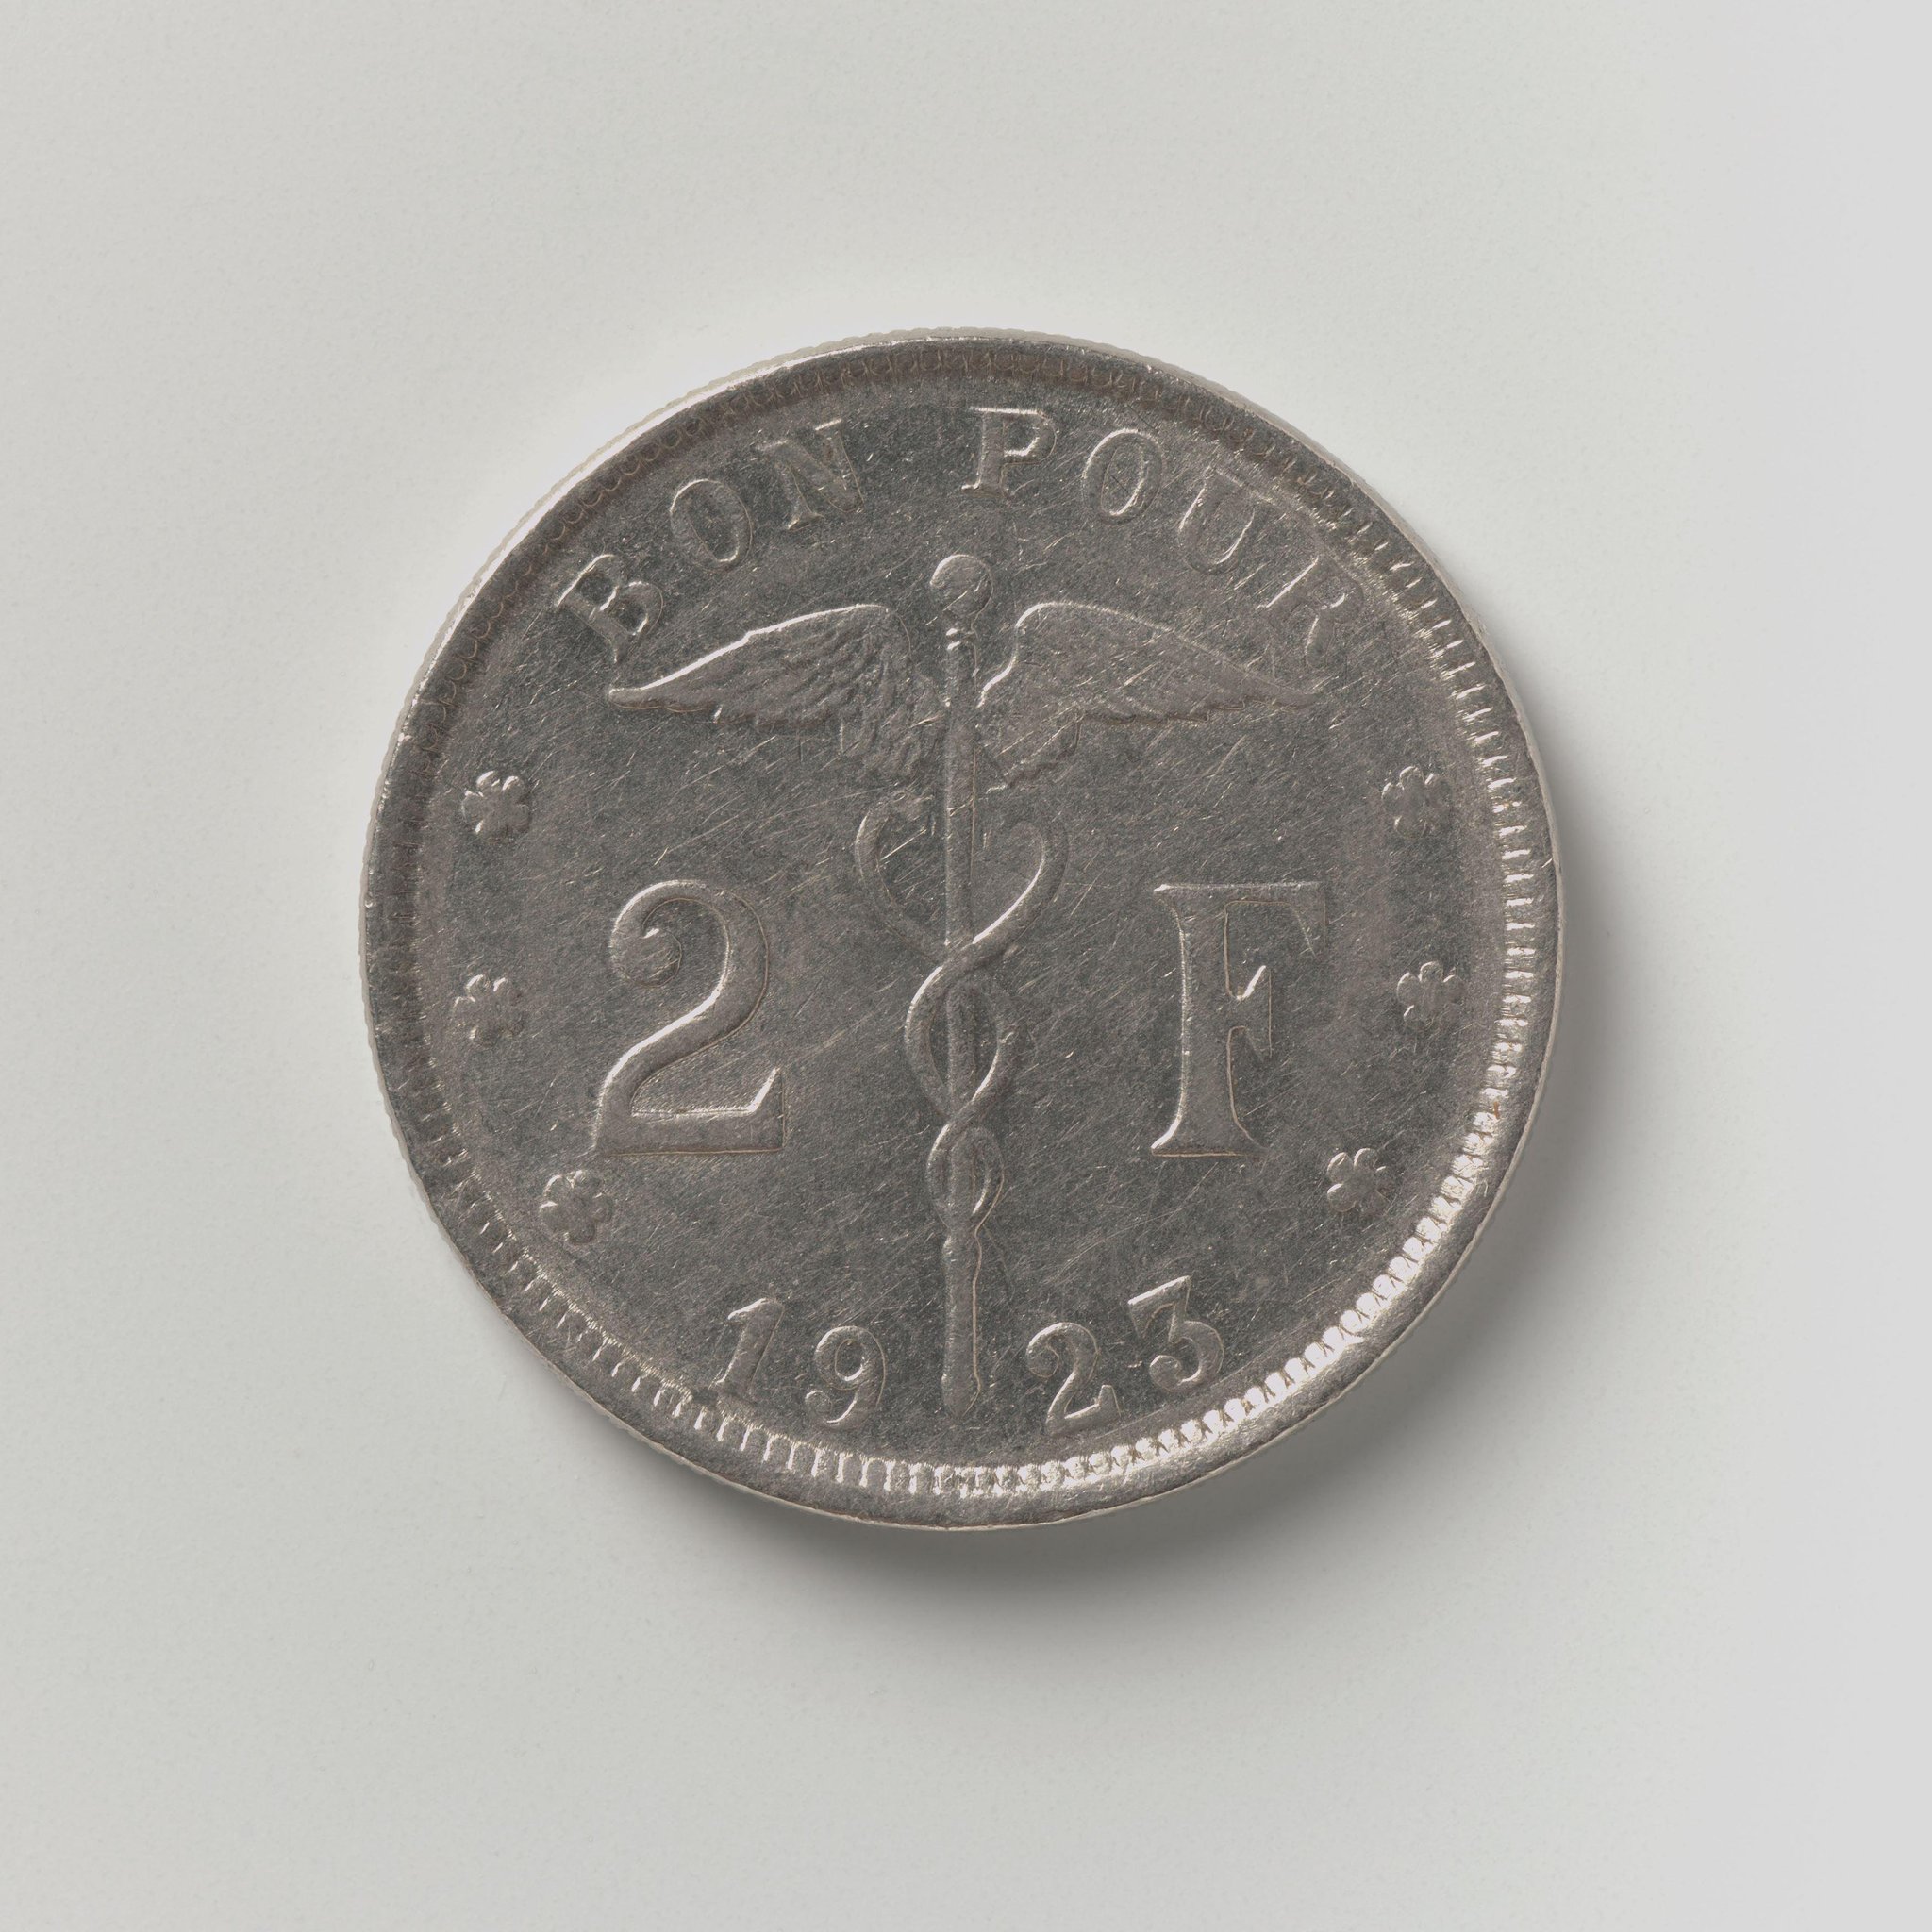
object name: coin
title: België, Albert I, 2 francs, 1923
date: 1923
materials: nickel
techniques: striking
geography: brussels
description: Nikkelen munt. Voorzijde: zittende vrouw naar links. Keerzijde: tussen waarde-aanduiding mercuriusstaf. Jaartal onderaan. Kartelrand.